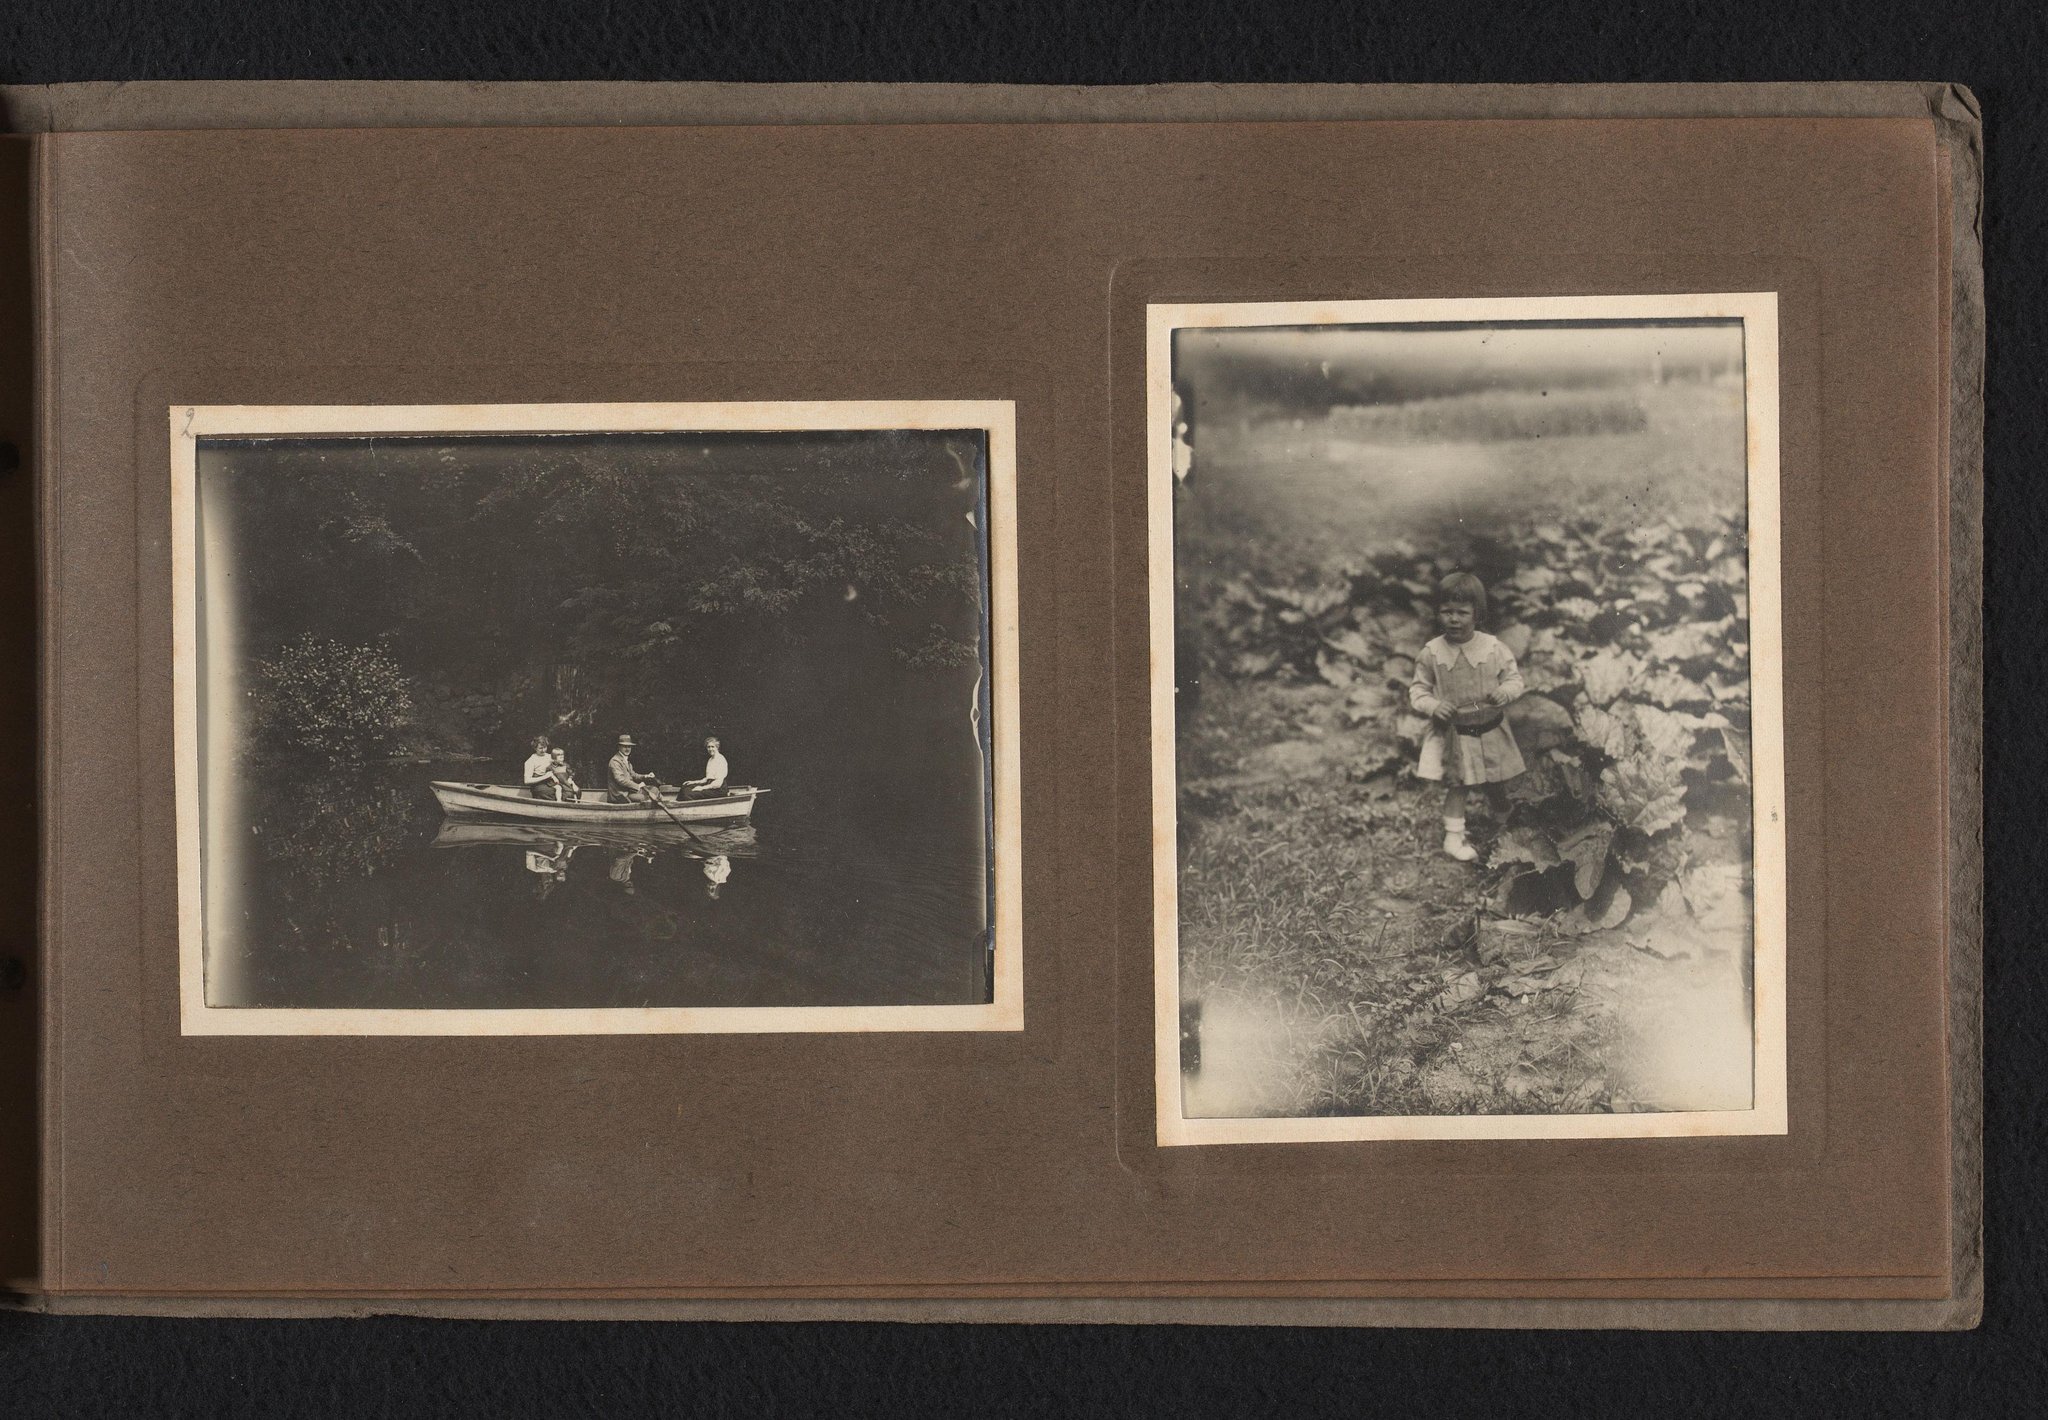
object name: photograph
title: Carel van den Berg met zijn vader en tantes in een roeiboot in Klarenbeek, rechts op een grasveld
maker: hendrik herman van den berg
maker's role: amateurfotograaf, jurist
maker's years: 1875-1944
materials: paper, cardboard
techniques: gelatin silver print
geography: klarenbeek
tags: batavia, hendrik herman van den berg, carel frederik van den berg (cay), rowing-boat, canoe, etc.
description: Deze foto's zijn onderdeel van een album.